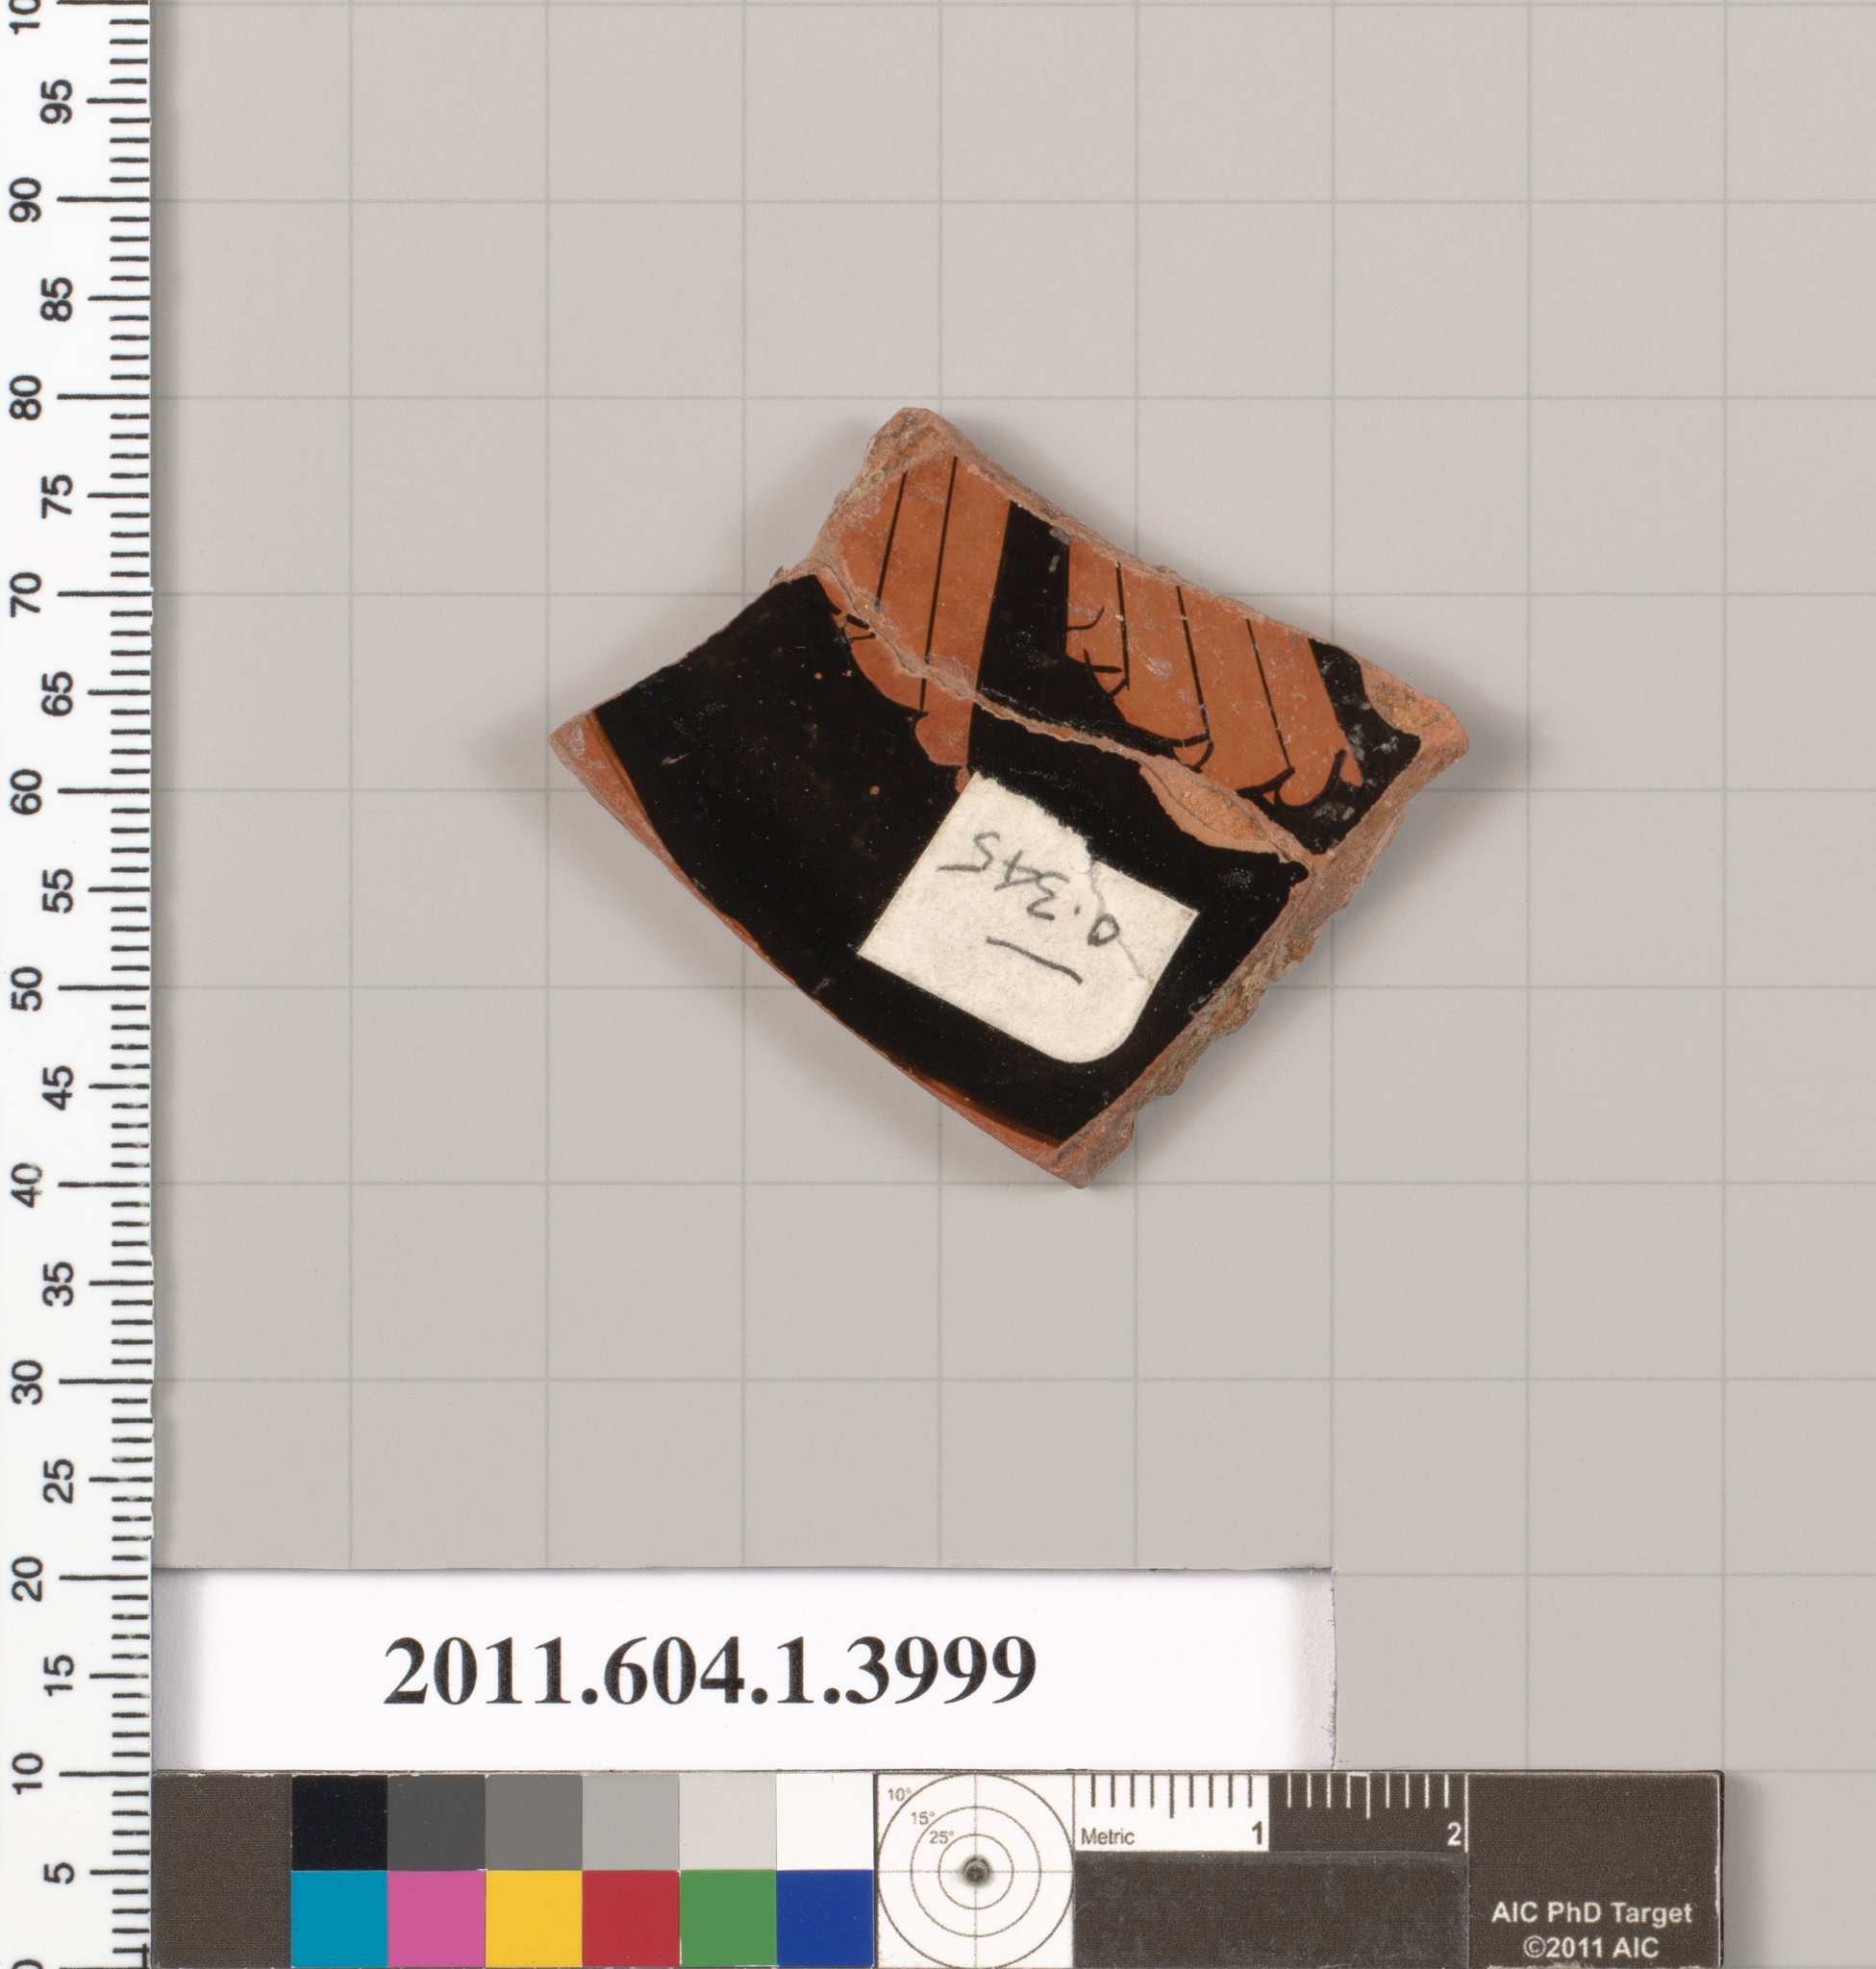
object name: kylix fragment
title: Terracotta fragment of a kylix (drinking cup)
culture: greek, attic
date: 510-490 BCE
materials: terracotta